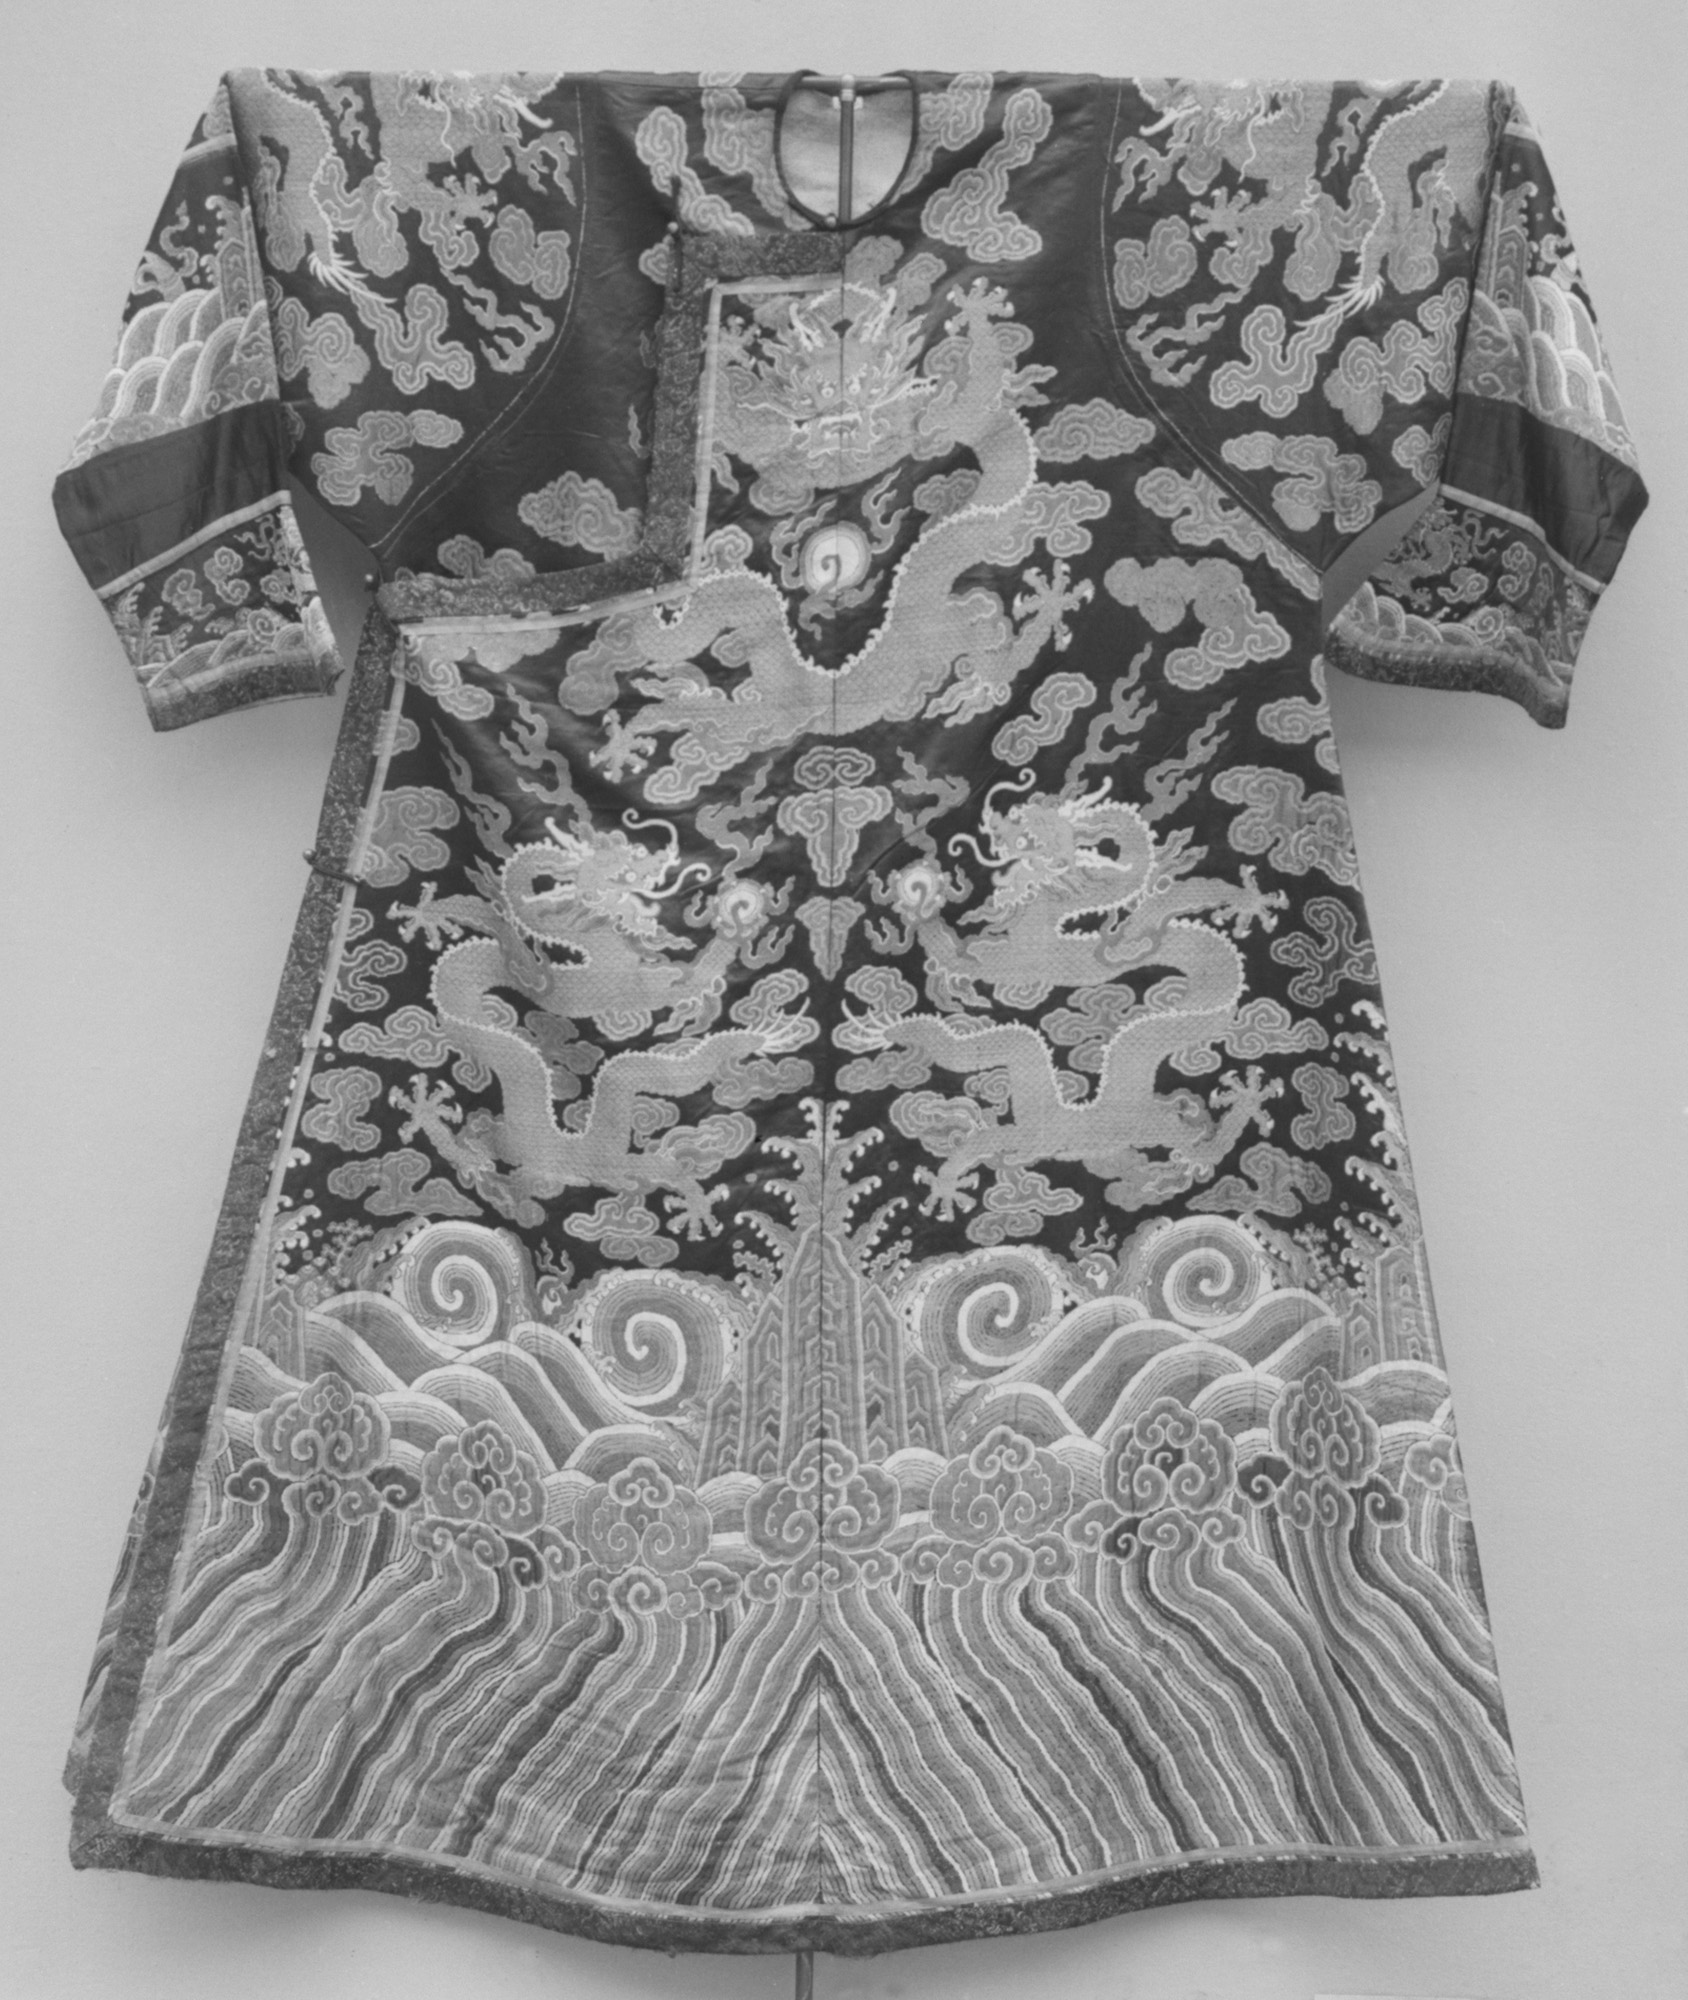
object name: robe, imperial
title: Imperial Summer Robe of State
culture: chinese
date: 1701-1800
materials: silk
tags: dragons